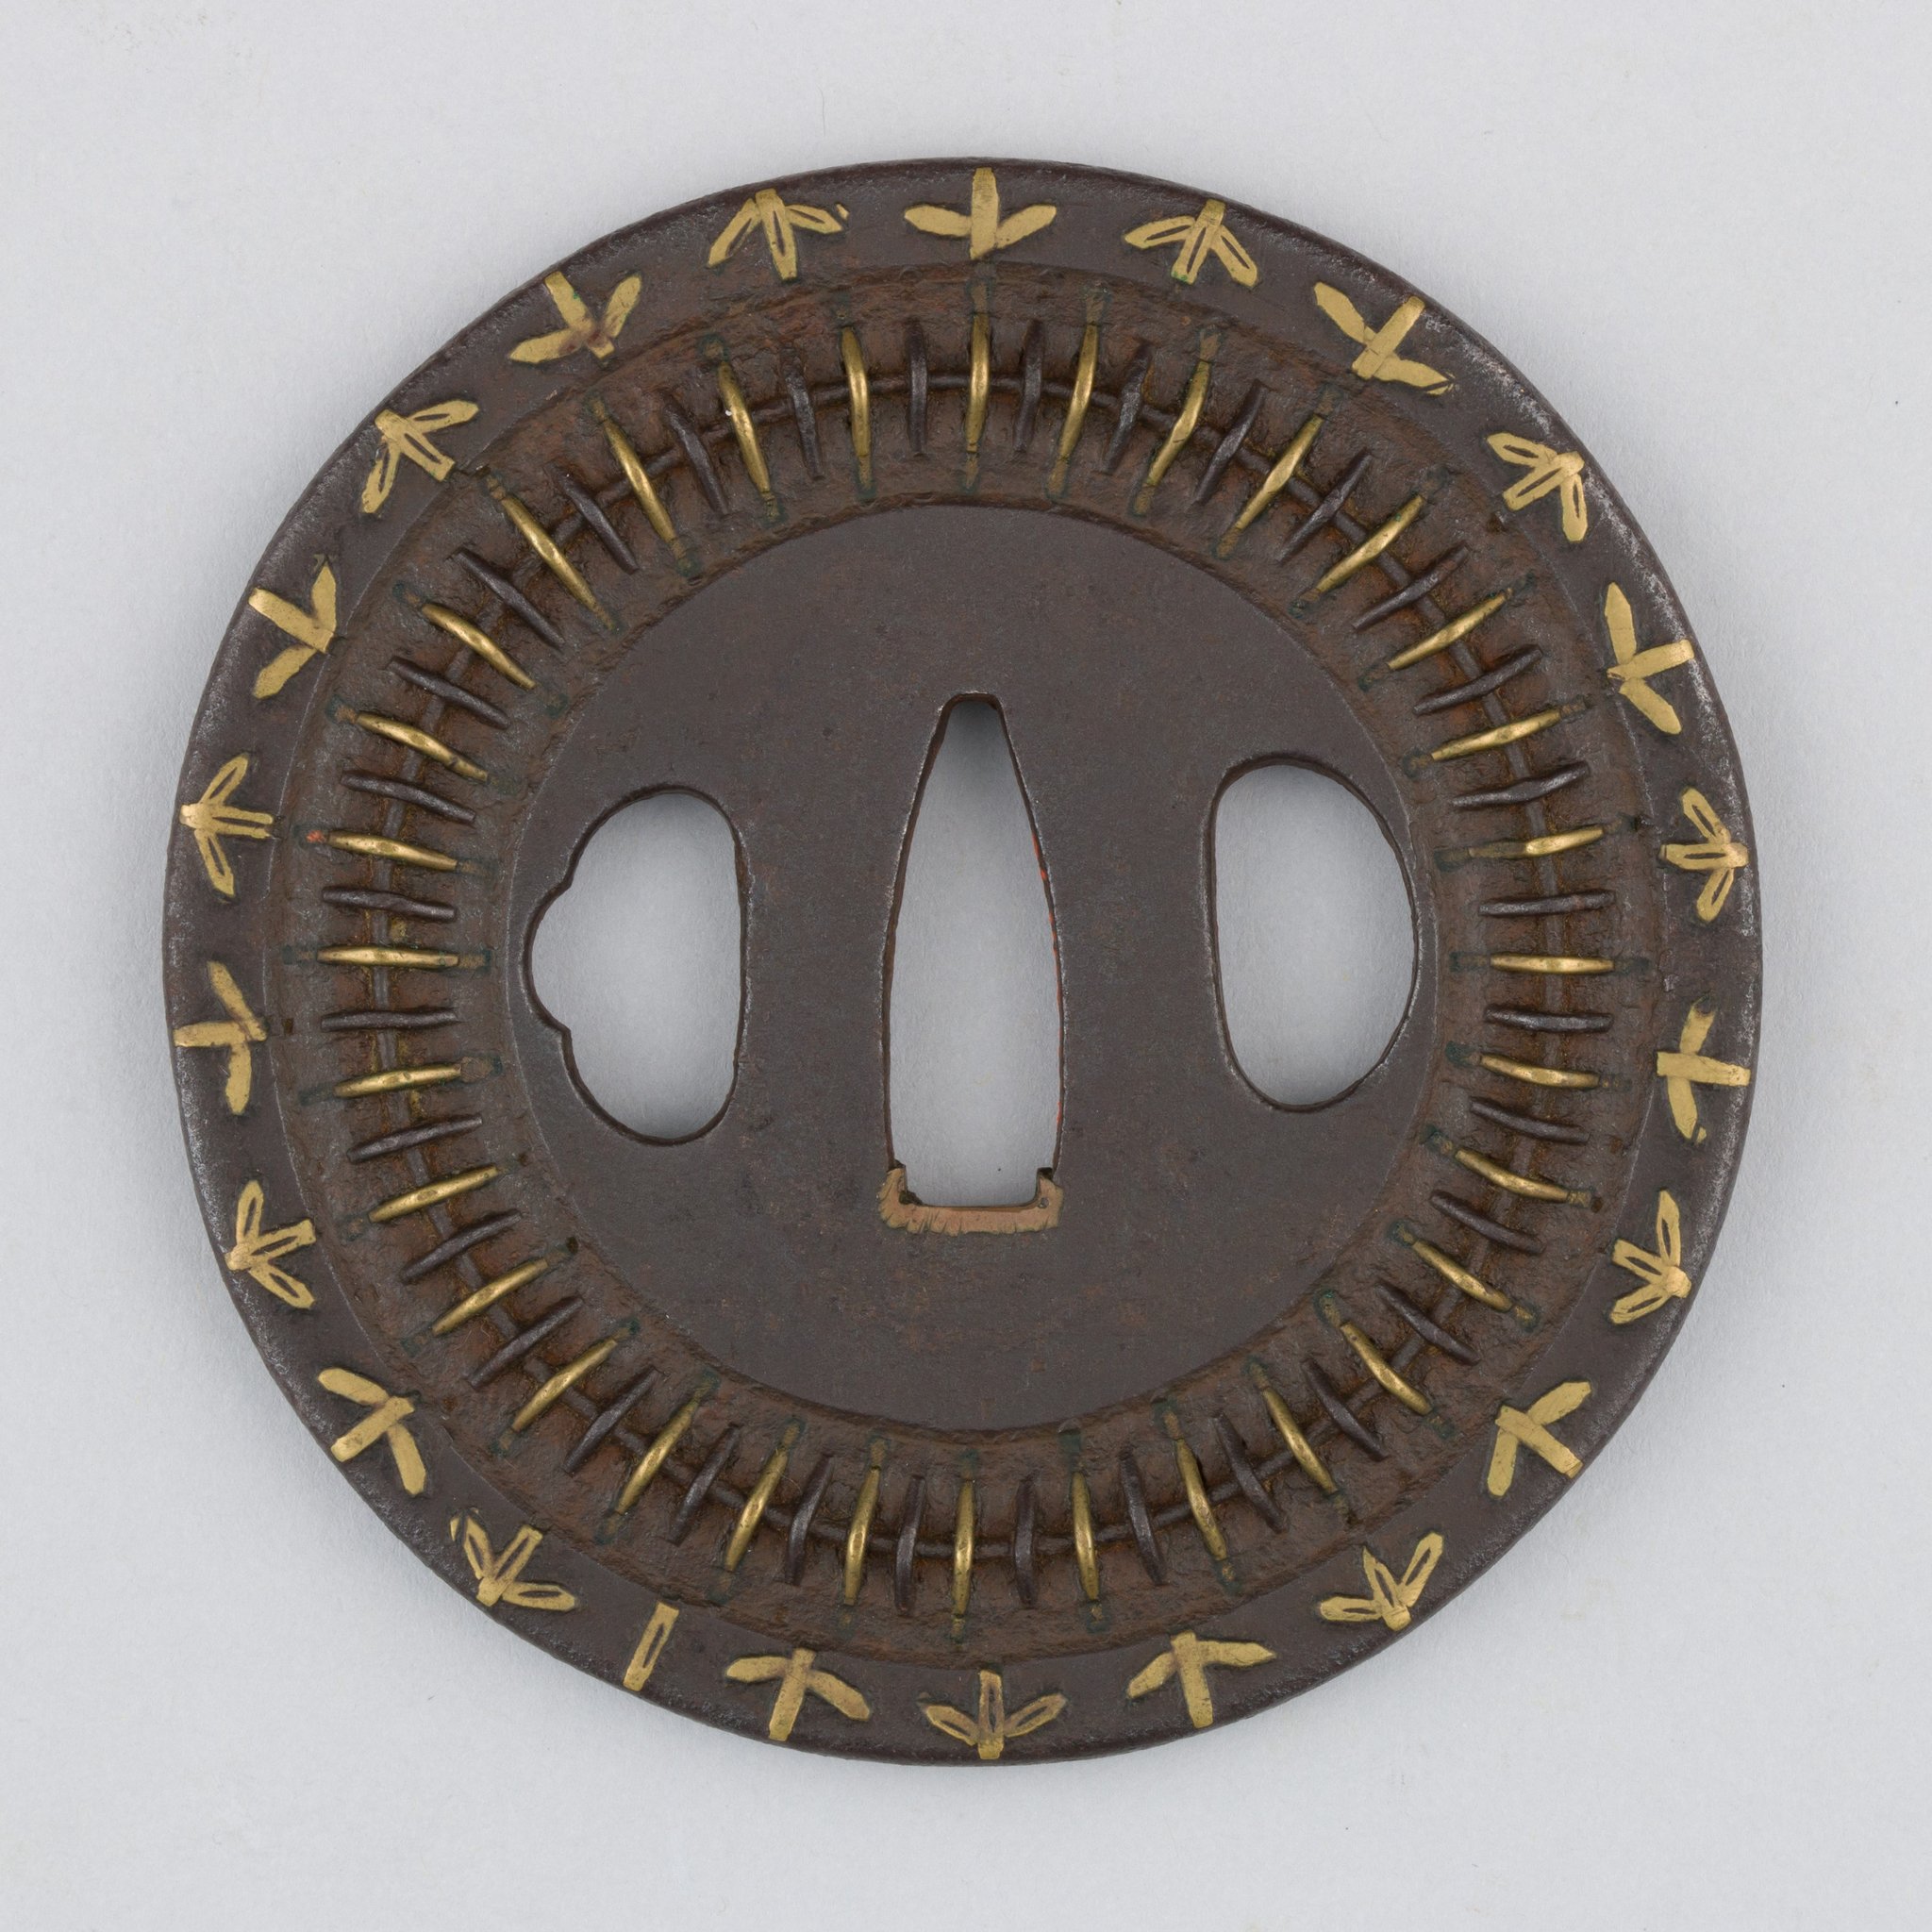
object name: sword guard tsuba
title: Sword Guard (Tsuba)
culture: japanese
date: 1701-1800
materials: brass, copper, iron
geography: japan